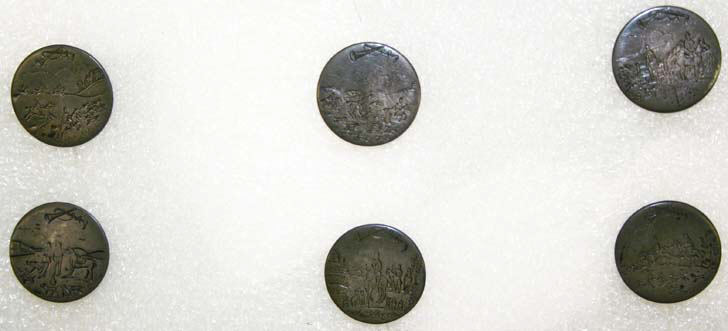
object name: button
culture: british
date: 1792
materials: metal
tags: hunting